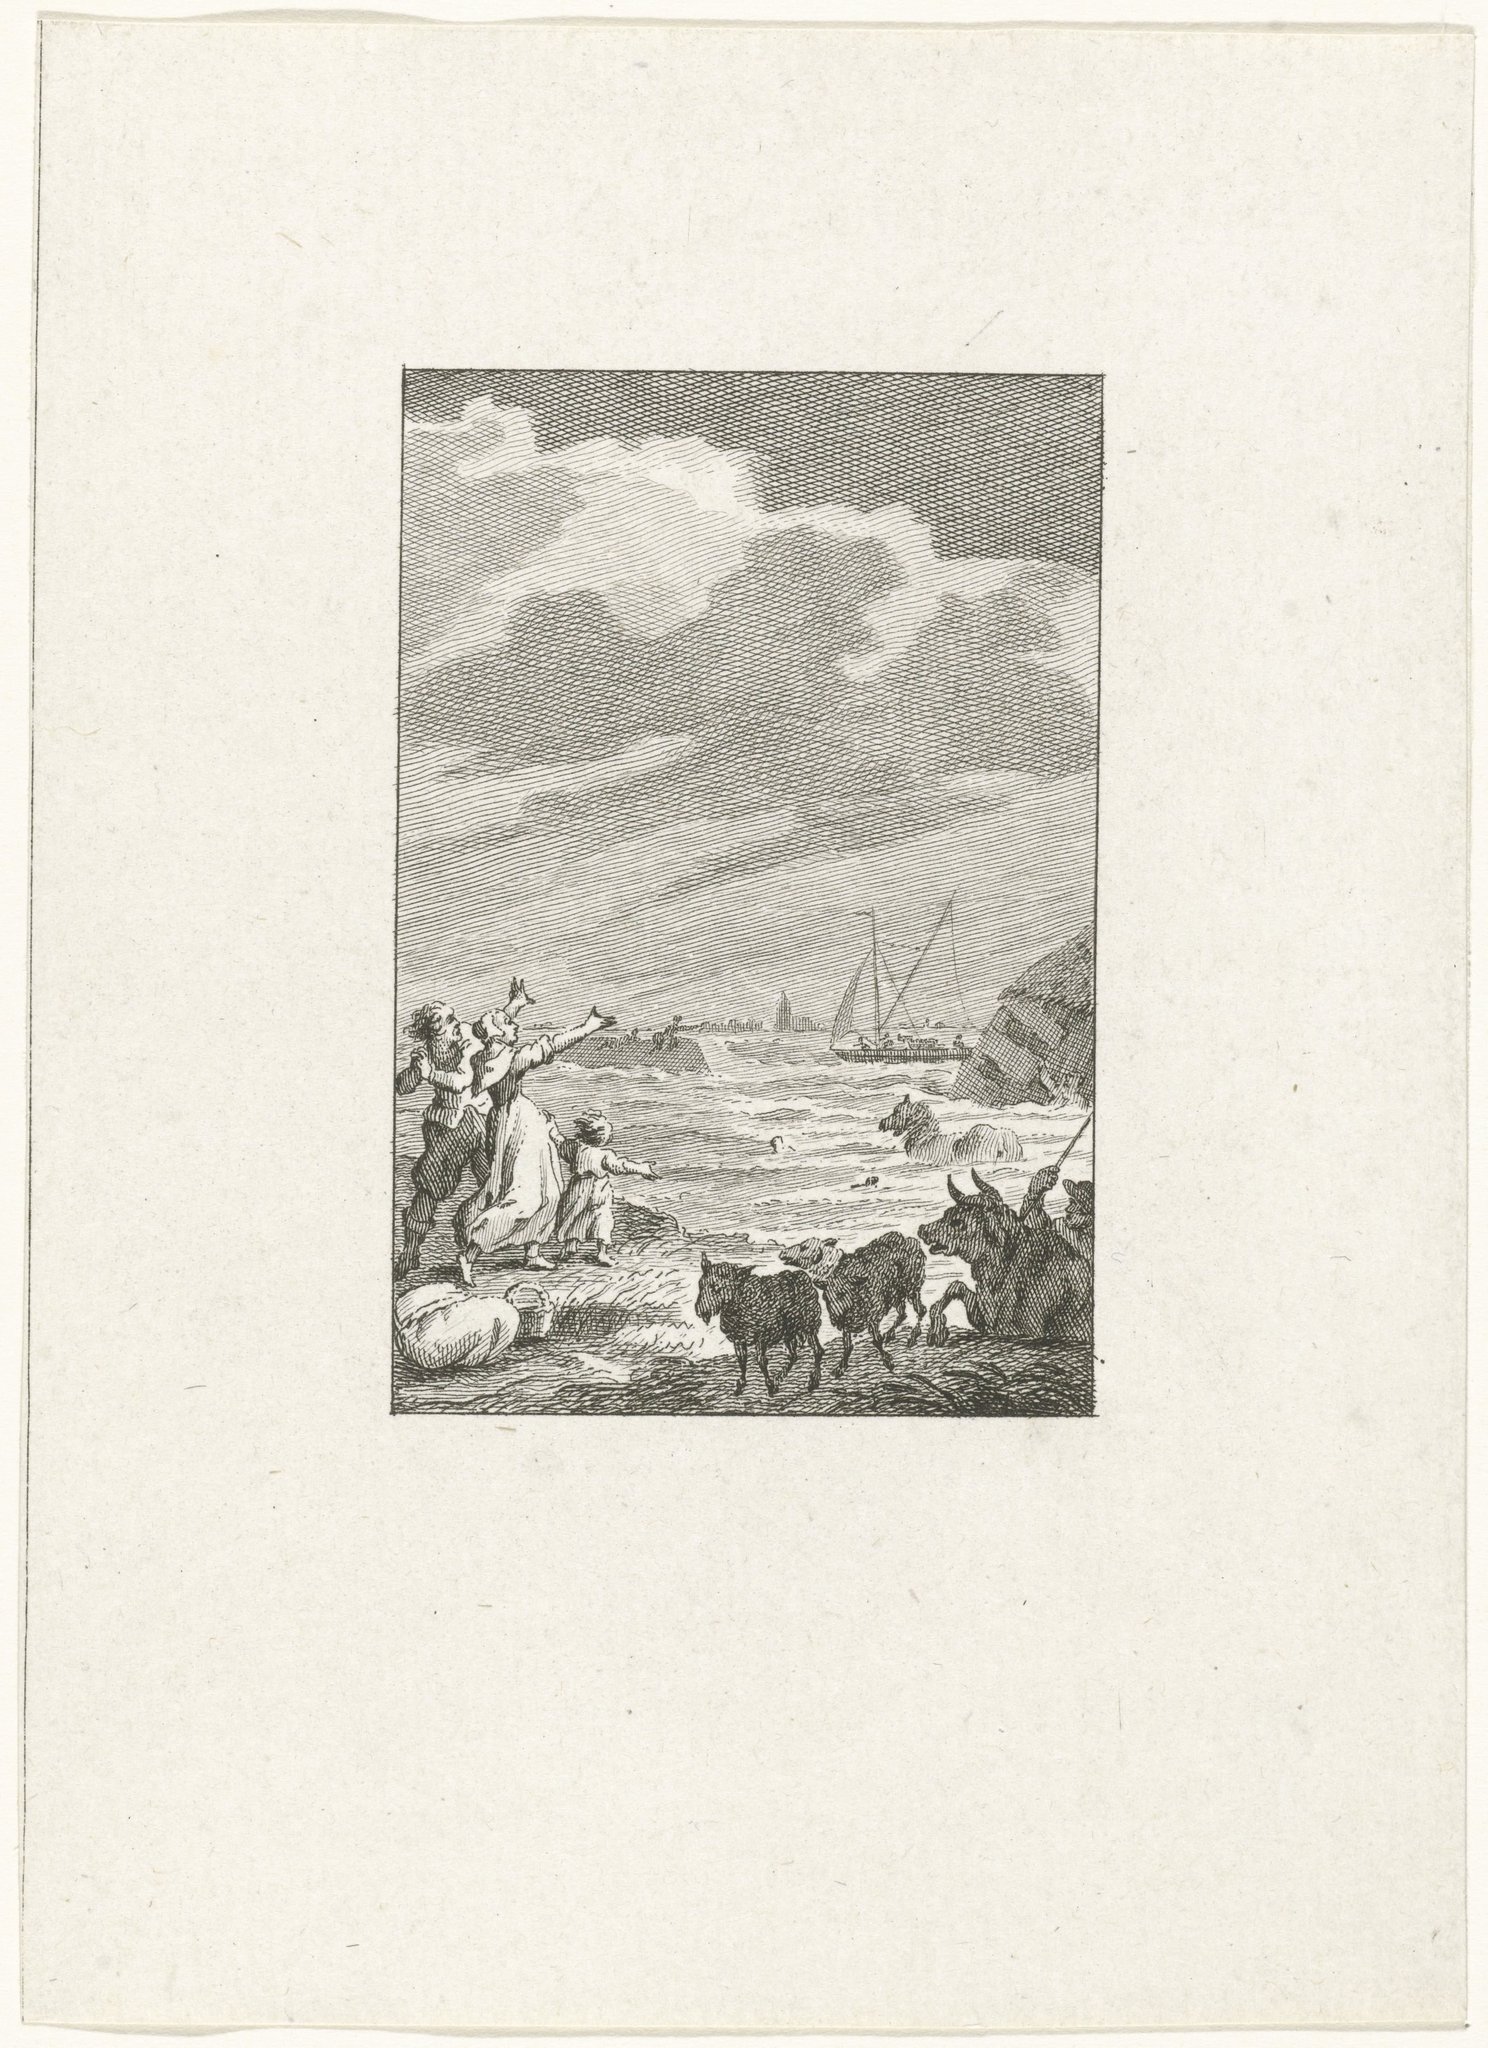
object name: print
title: Watersnood van 1775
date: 1783-1795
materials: paper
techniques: engraving, etching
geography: northern netherlands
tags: dike-break, the flood of 14-18 november 1775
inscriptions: collector's mark: Lugt 2228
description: Gebruikt als illustratie in: J. Fokke, Geschiedenissen der Vereenigde Nederlanden voor de vaderlandsche jeugd, Johannes Allart, Amsterdam 1783-1795, 25 delen.